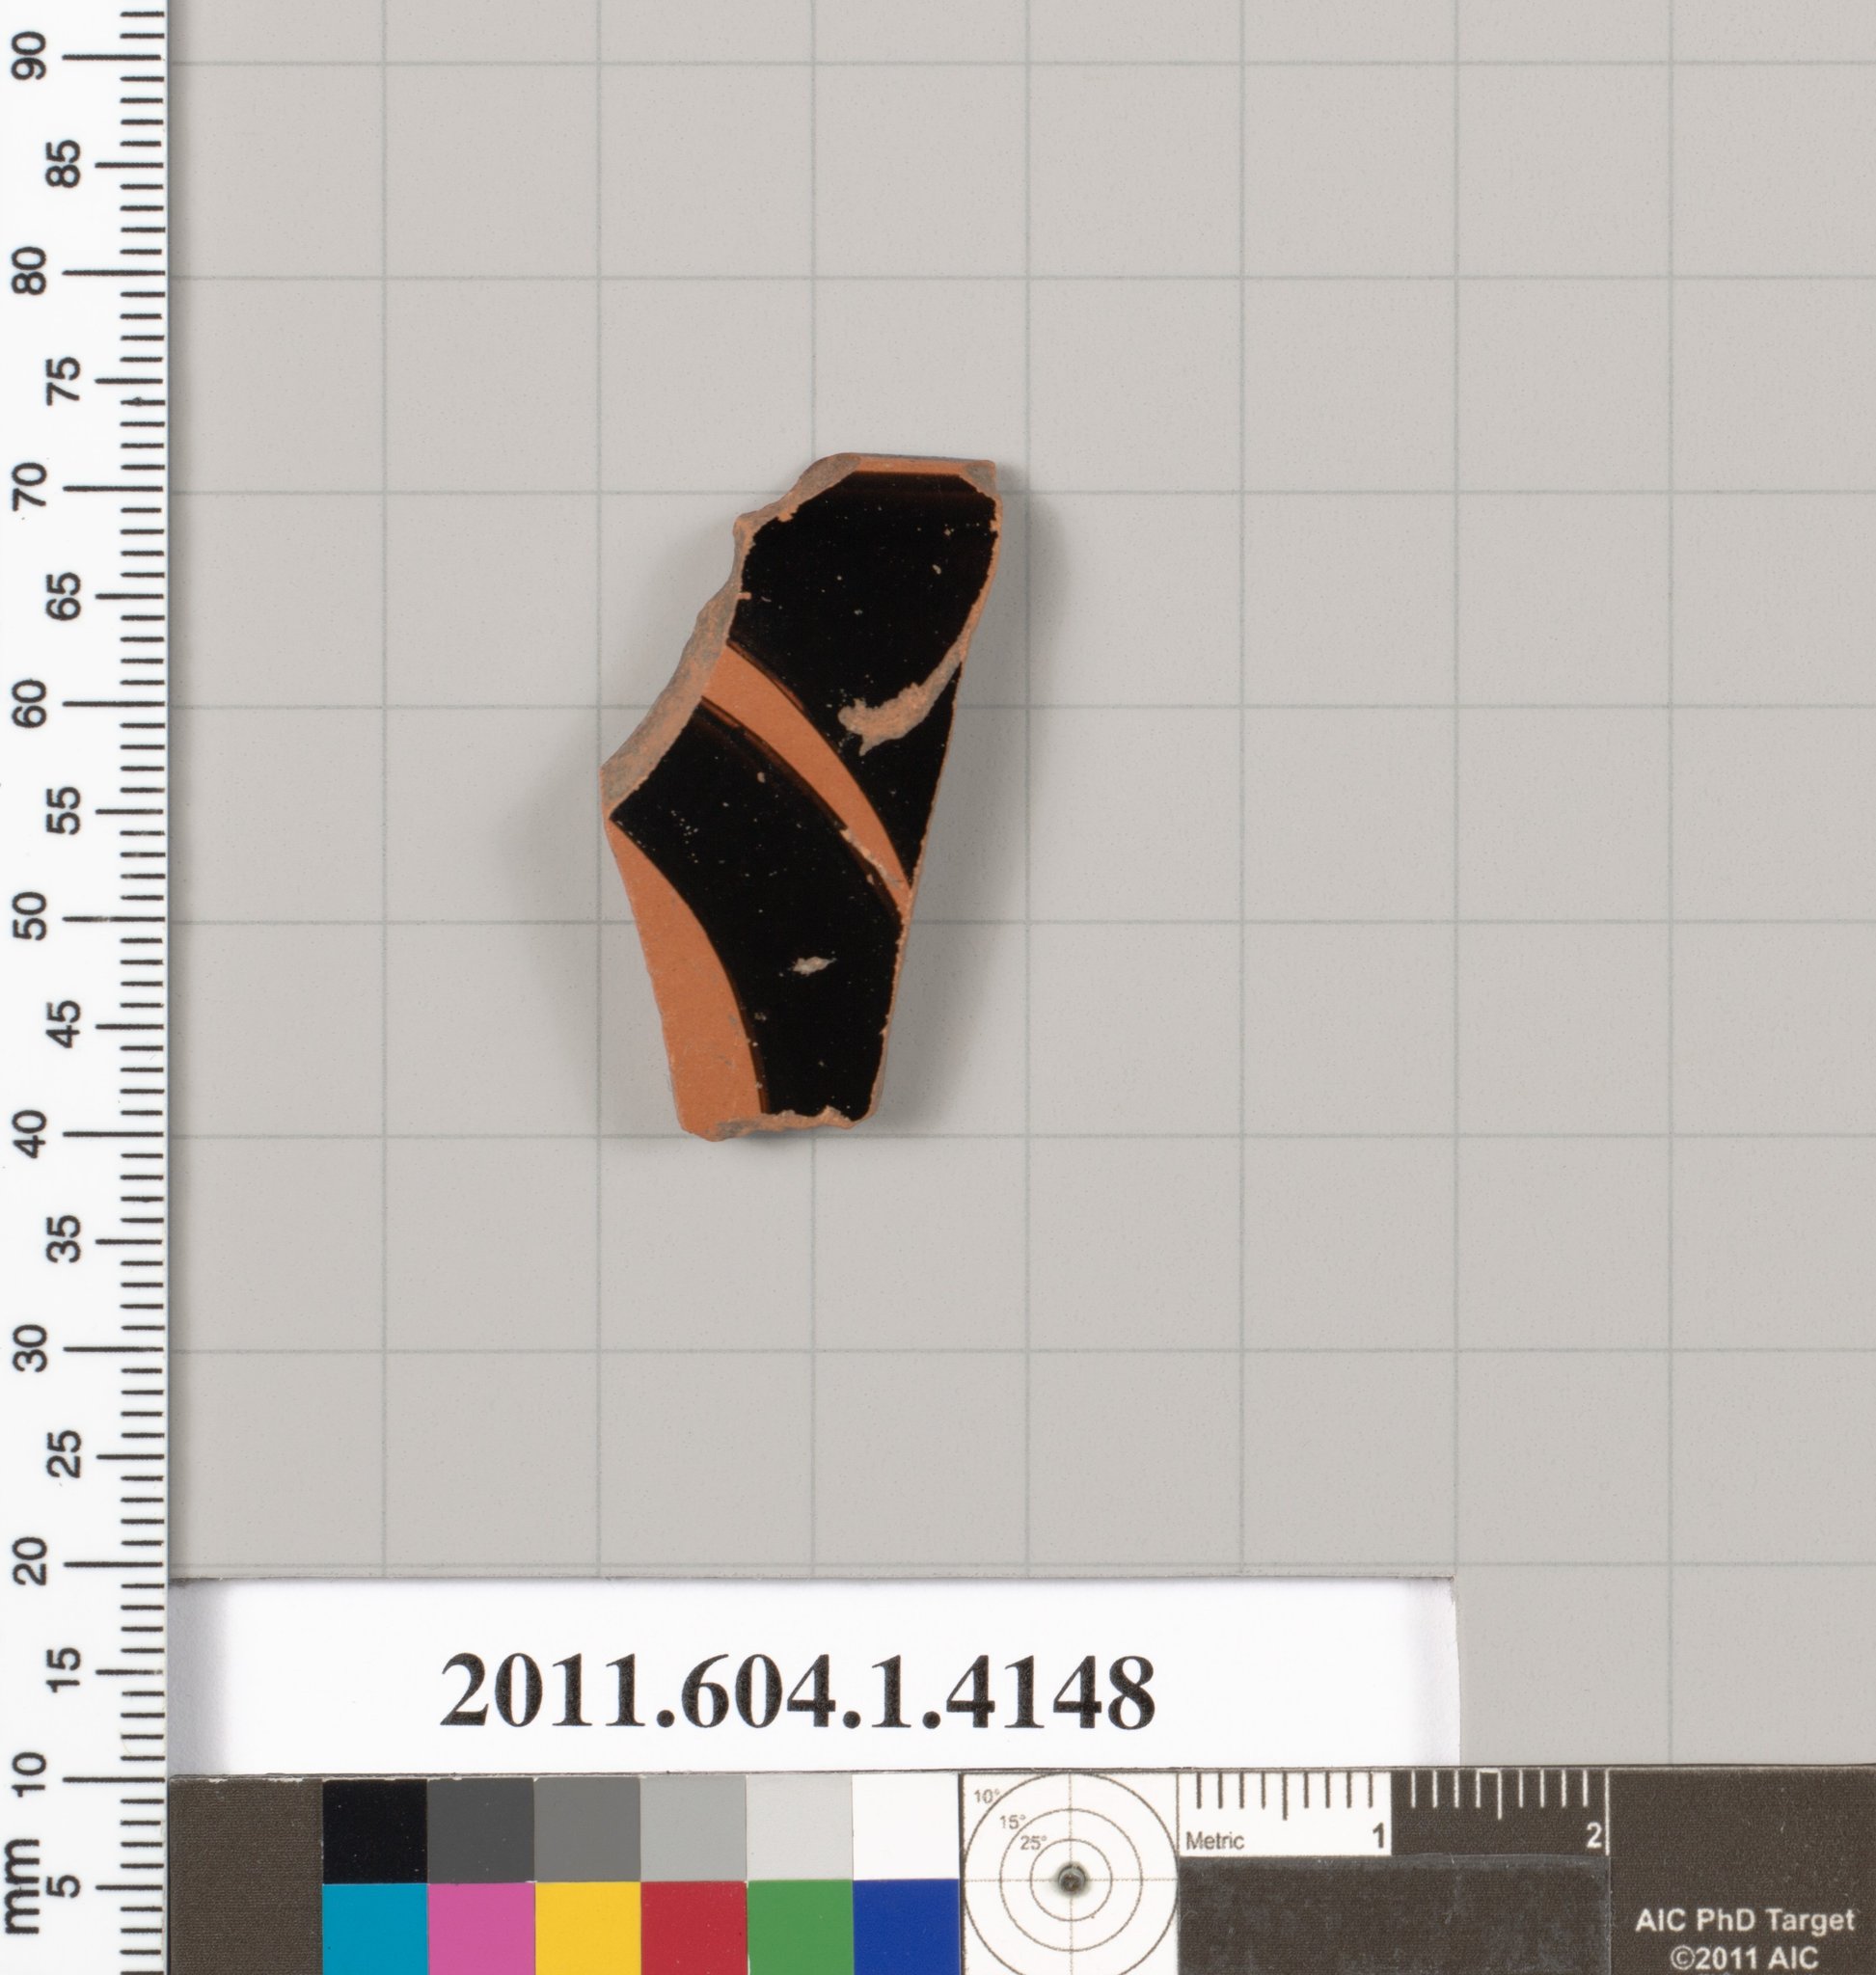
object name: kylix fragment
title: Terracotta rim fragment of a kylix (drinking cup)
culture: greek, attic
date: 520-500 BCE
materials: terracotta